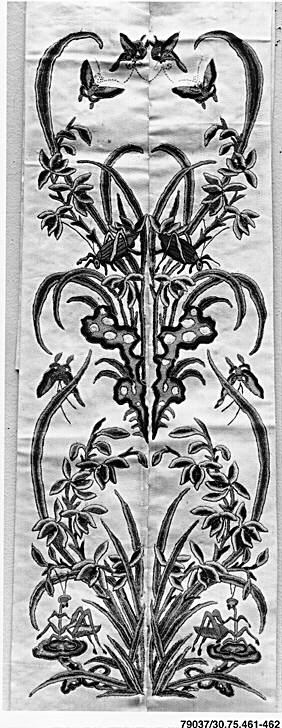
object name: sleeve band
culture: chinese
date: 1801-1900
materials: metal thread, silk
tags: butterflies,leaves